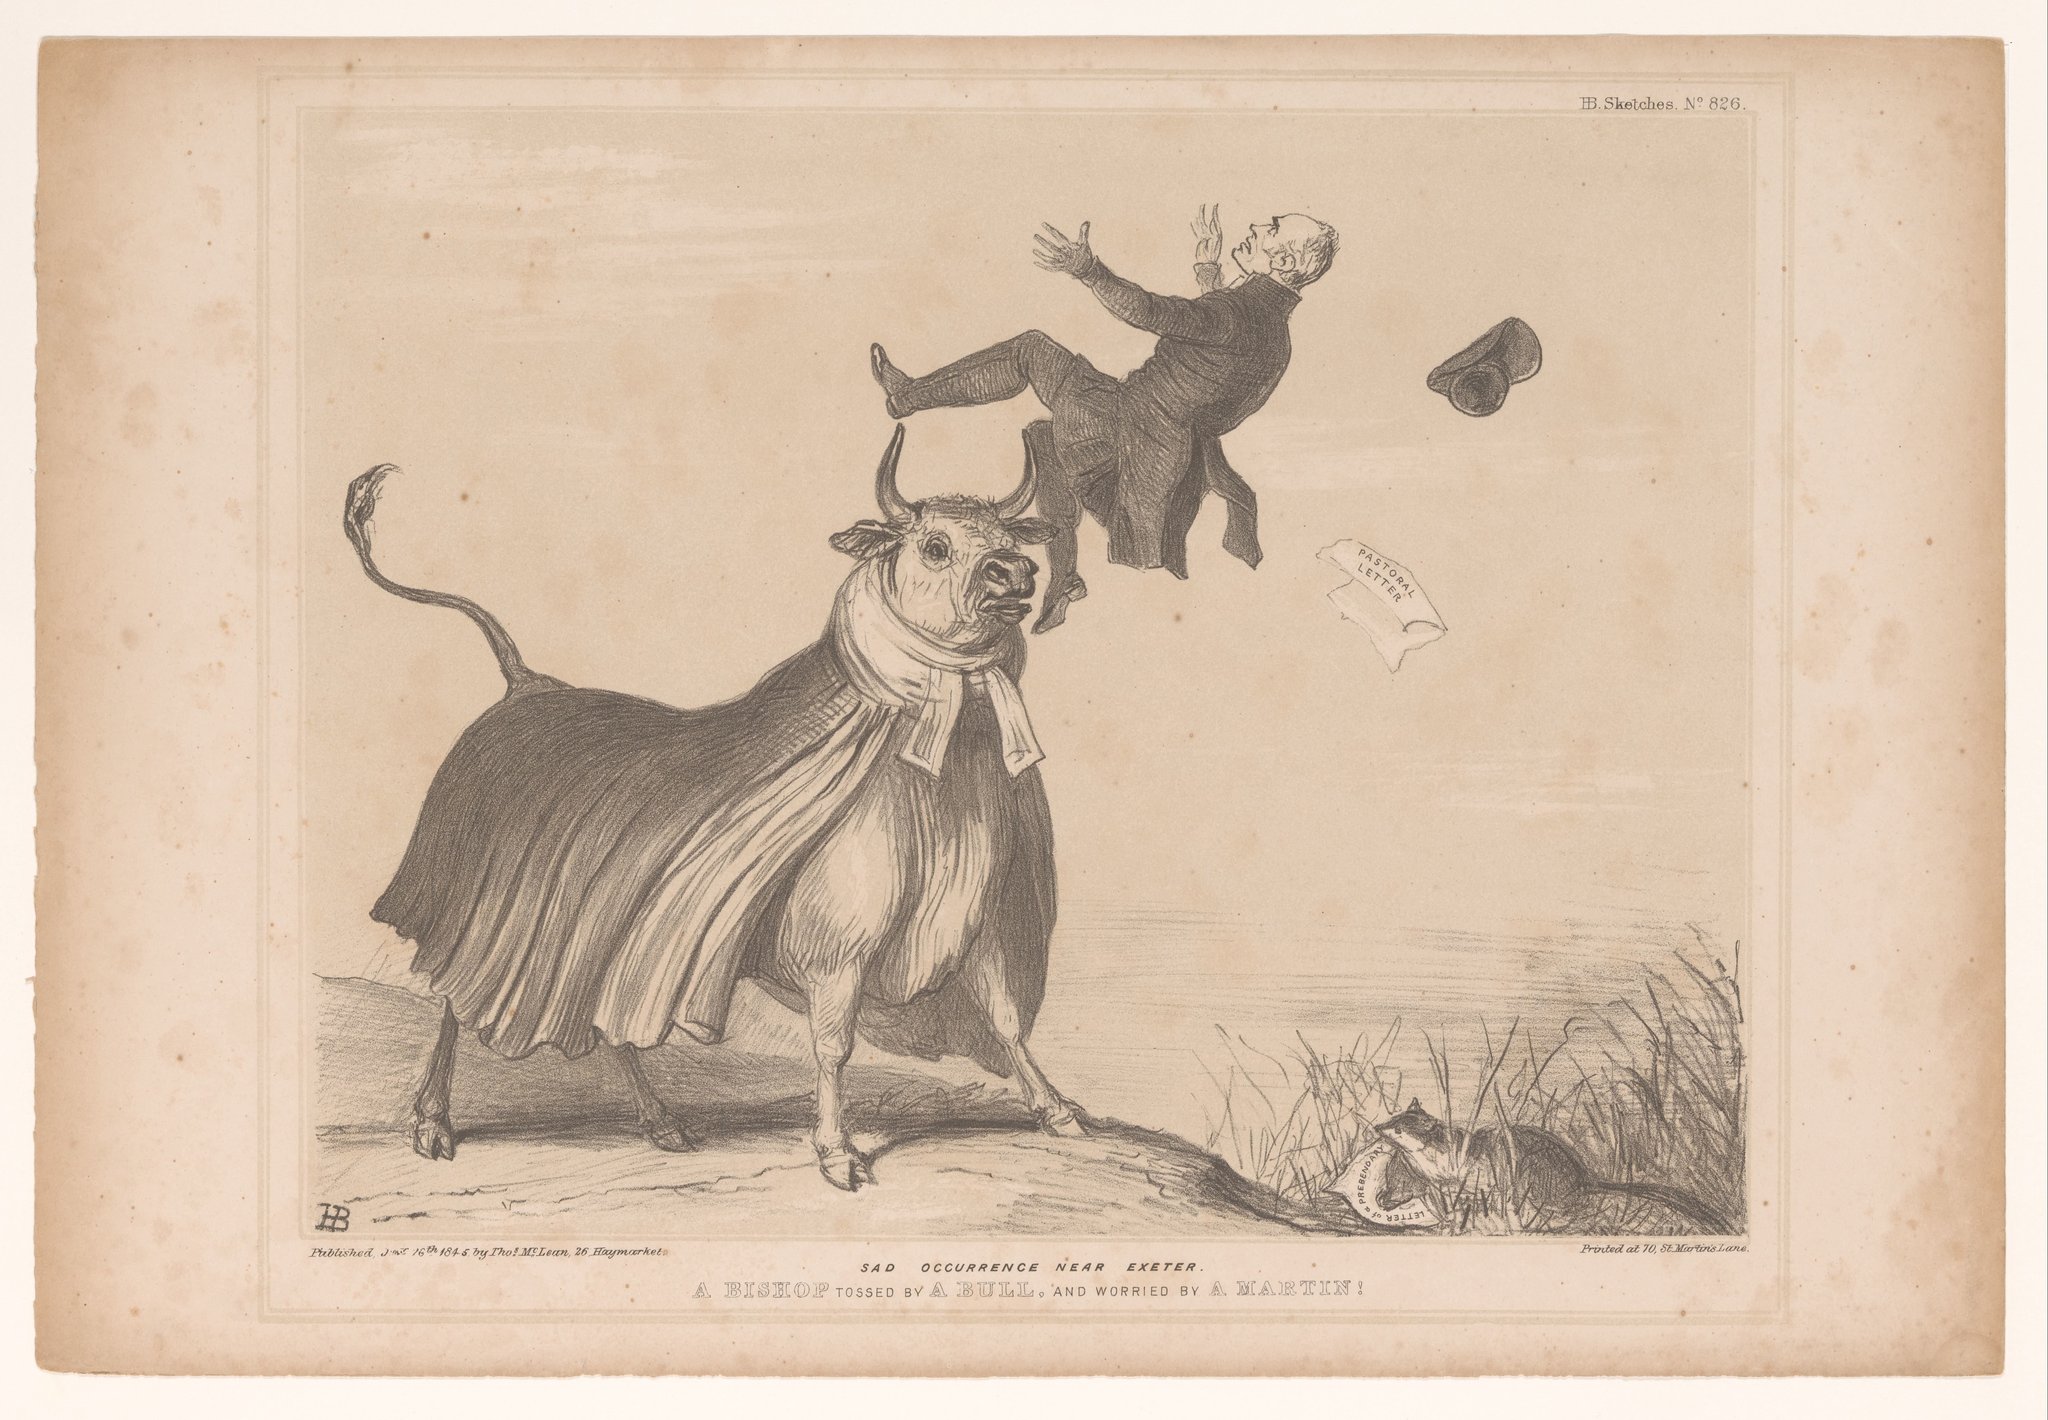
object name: print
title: HB Sketches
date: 1845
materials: paper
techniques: tone lithography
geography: london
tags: bull, political caricatures and satires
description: Spotprent uit 1845 waarin de bisschop van Exeter door een stier op de horens wordt genomen. Uitgegeven als nr. 826 in de serie HB Sketches.